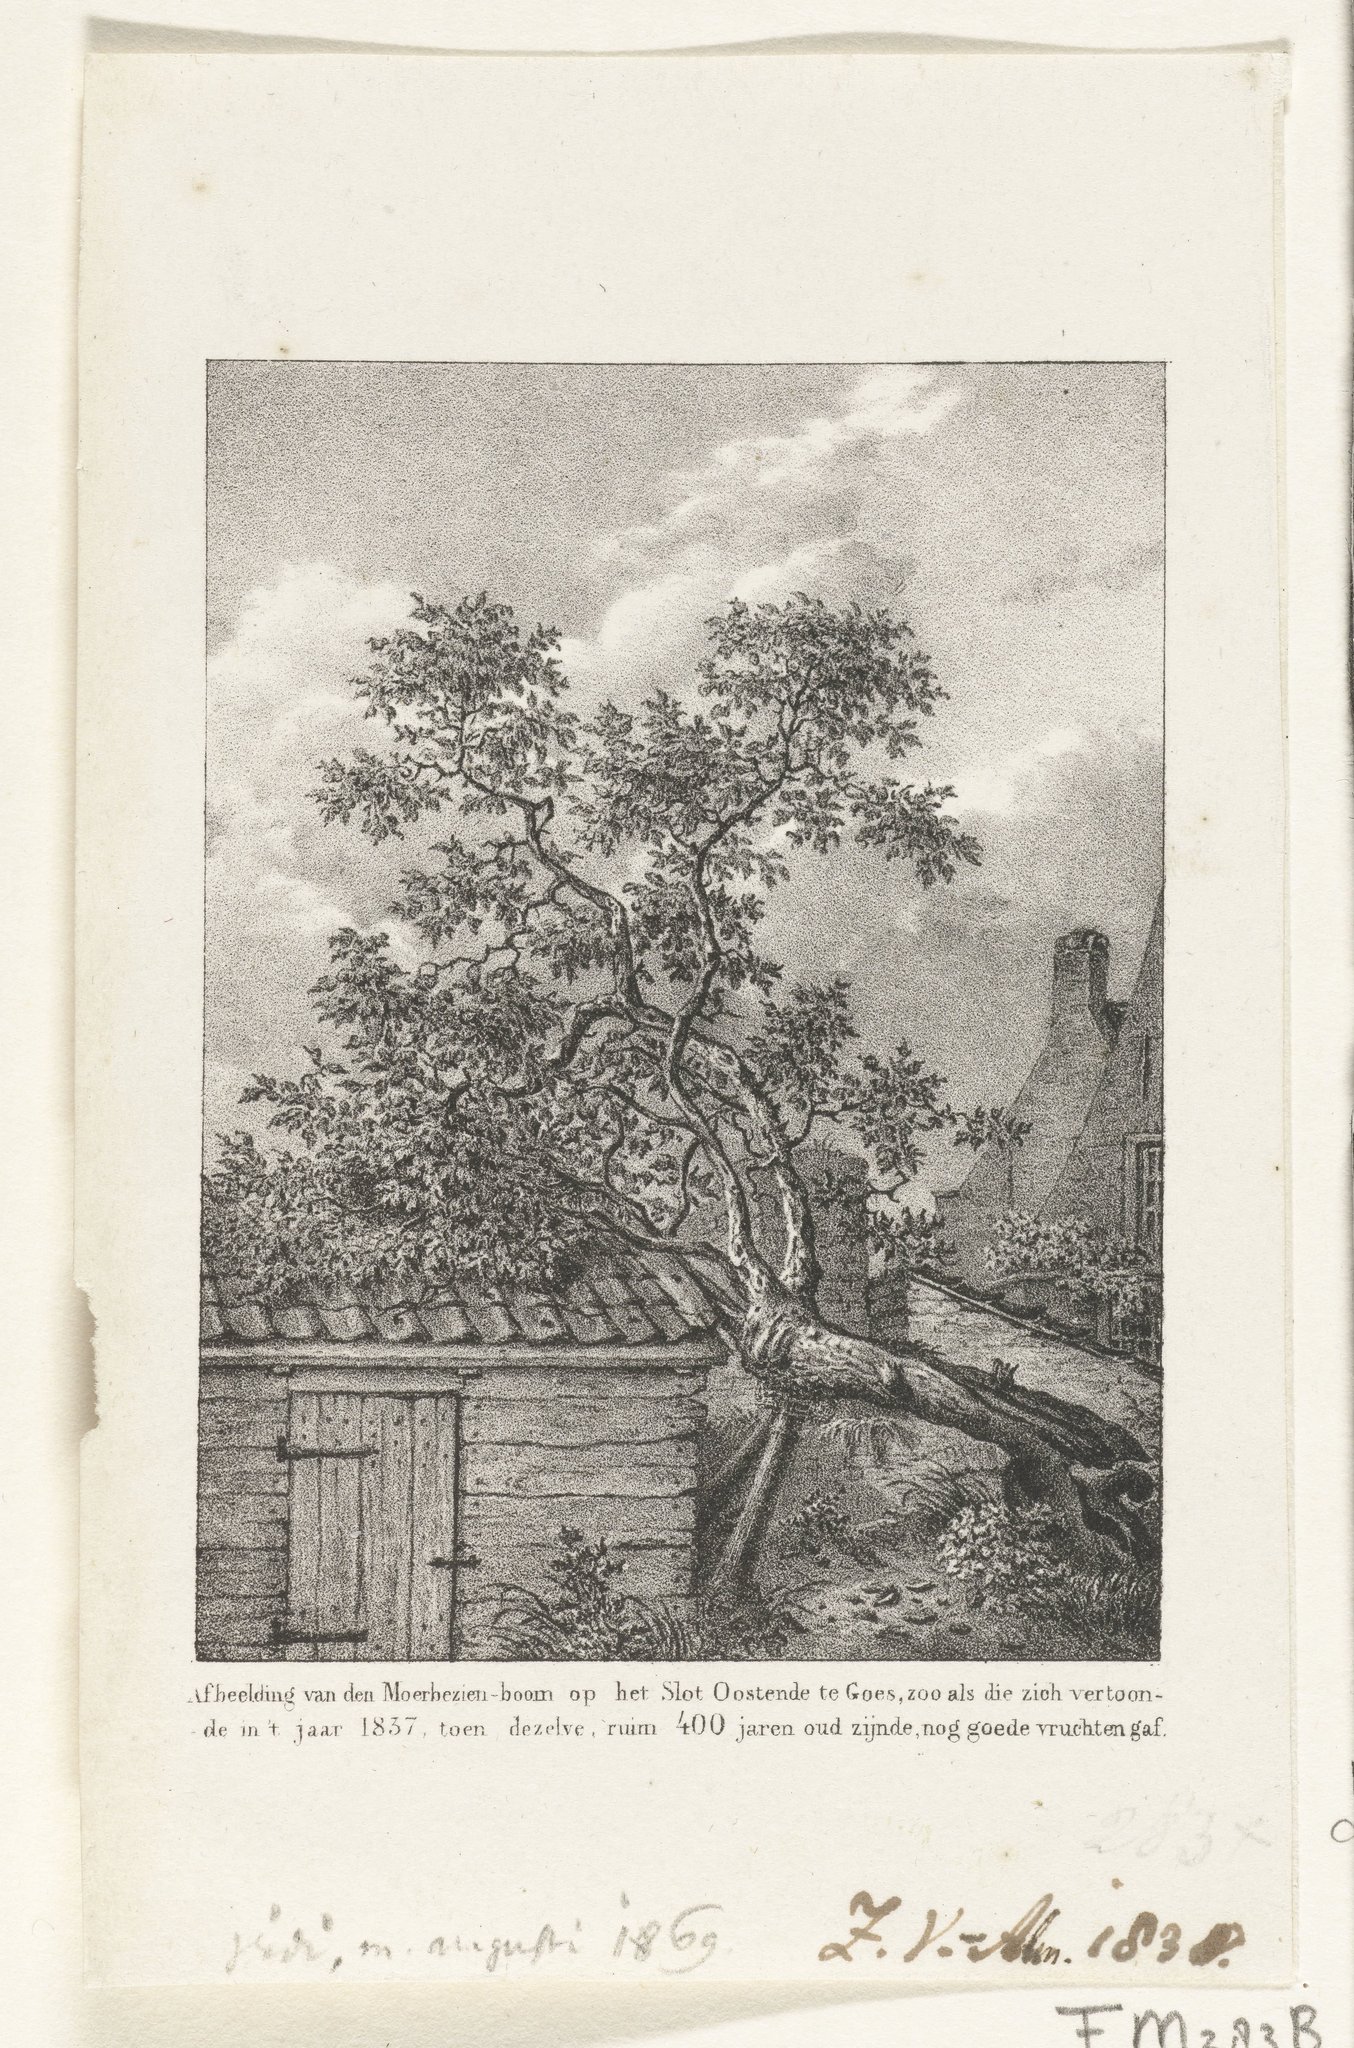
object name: history print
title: Afbeelding van den Moerbezien-boom op het Slot Oostende te Goes, zoo als die zich vertoonde in 't jaar 1837, toen dezelve, ruim 400 jaren oud zijnde, nog goede vruchten gaf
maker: Anonymous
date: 1836-1838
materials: paper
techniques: lithograph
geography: netherlands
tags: jacoba of bavaria (countess of hainaut), trees: mulberry-tree, burgundian netherlands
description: Oude moerbeiboom op het Slot Oostende te Goes in 1837, toen deze ruim 400 jaar oude boom, nog goede vruchten gaf. De boom zou zijn geplant door Jacoba van Beieren.